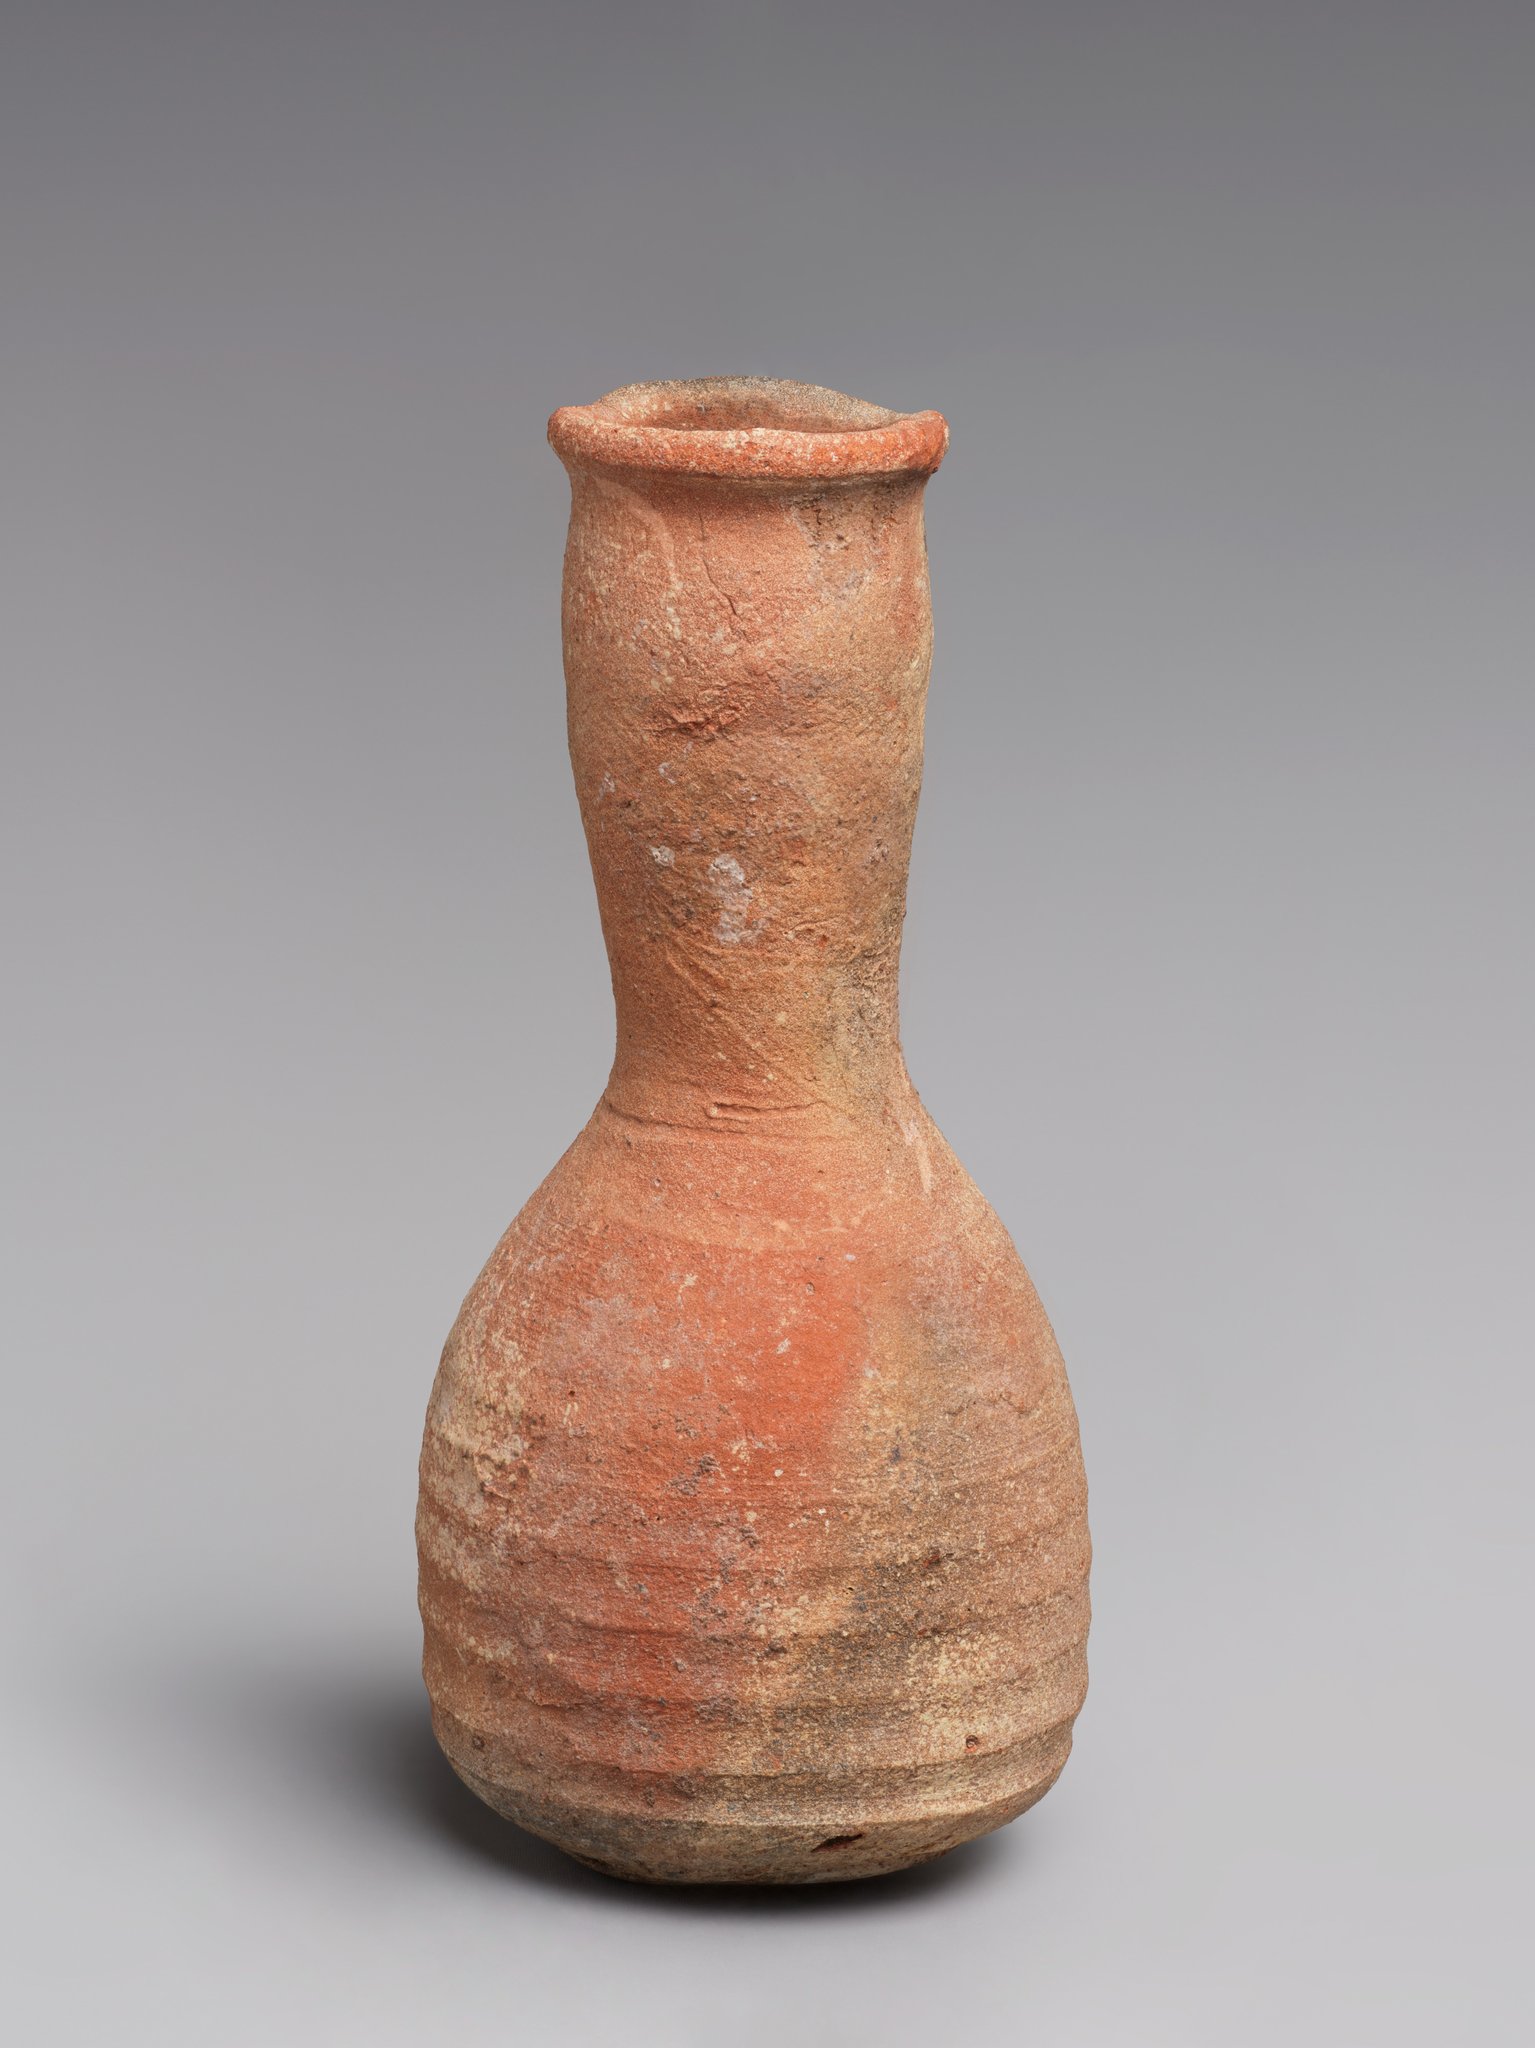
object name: vessel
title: Unguentarium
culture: nabataean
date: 1-100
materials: ceramic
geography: levant